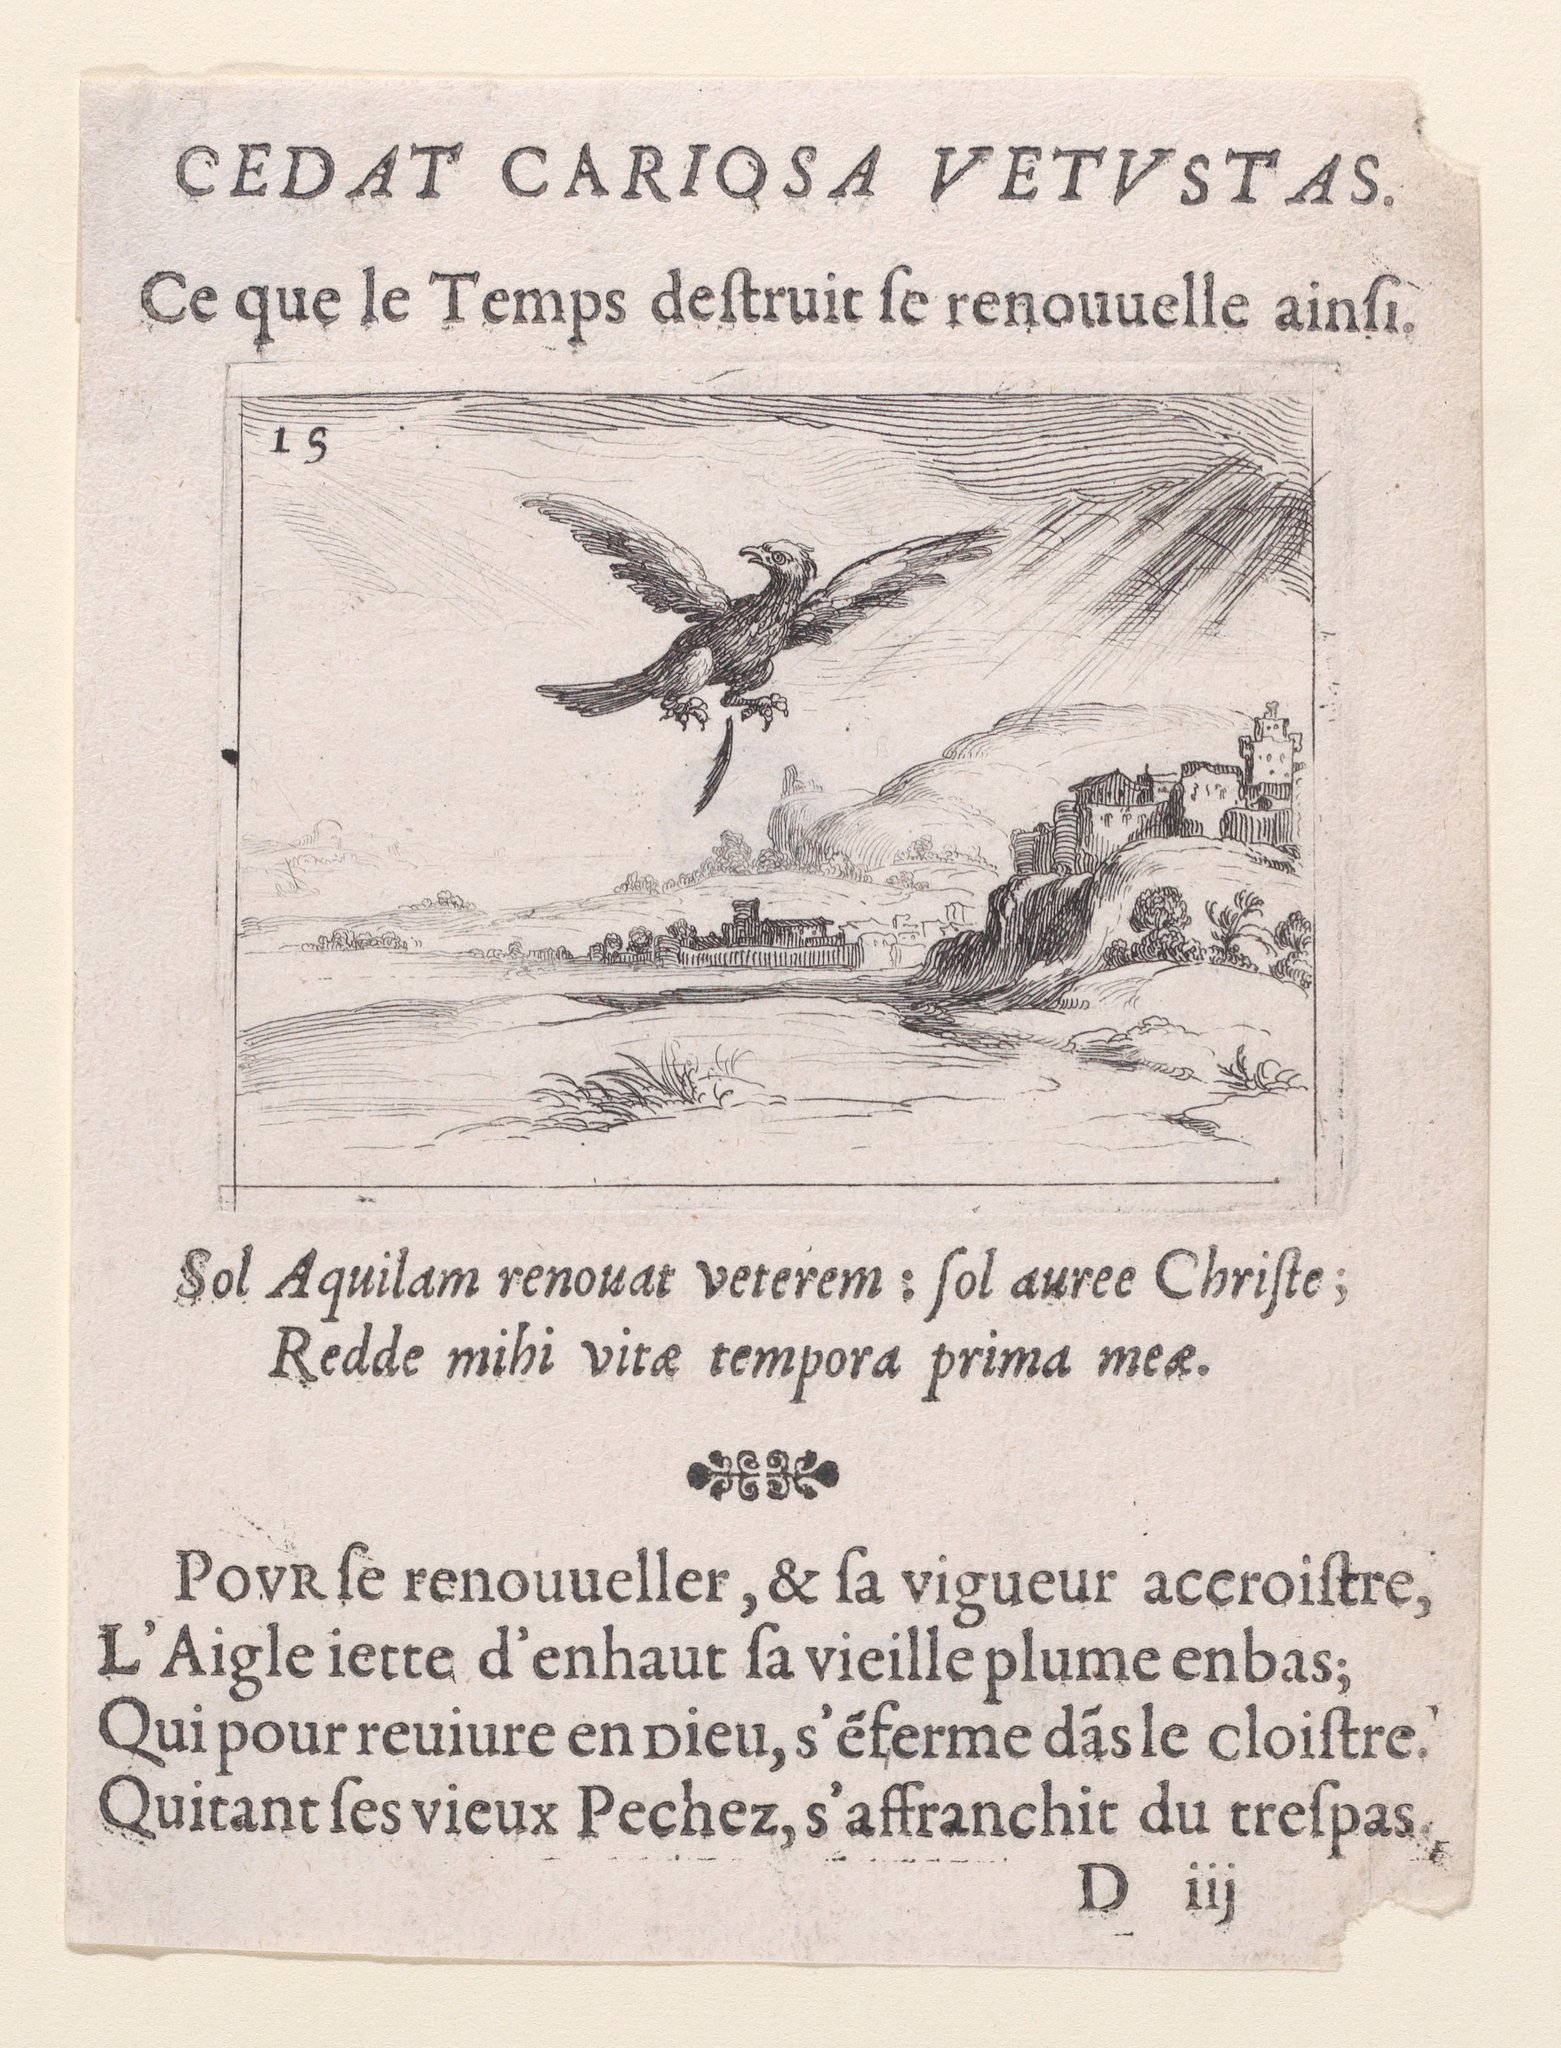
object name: print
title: Un Aigle Jetant une Vieille Plume (An Eagle Dropping an Old Feather), plate 15 from "Lux Claustri ou La Lumière du Cloitre" (The Light of the Cloisters)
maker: jacques callot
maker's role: artist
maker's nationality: french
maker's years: 1592-1635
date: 1621-1635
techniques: etching